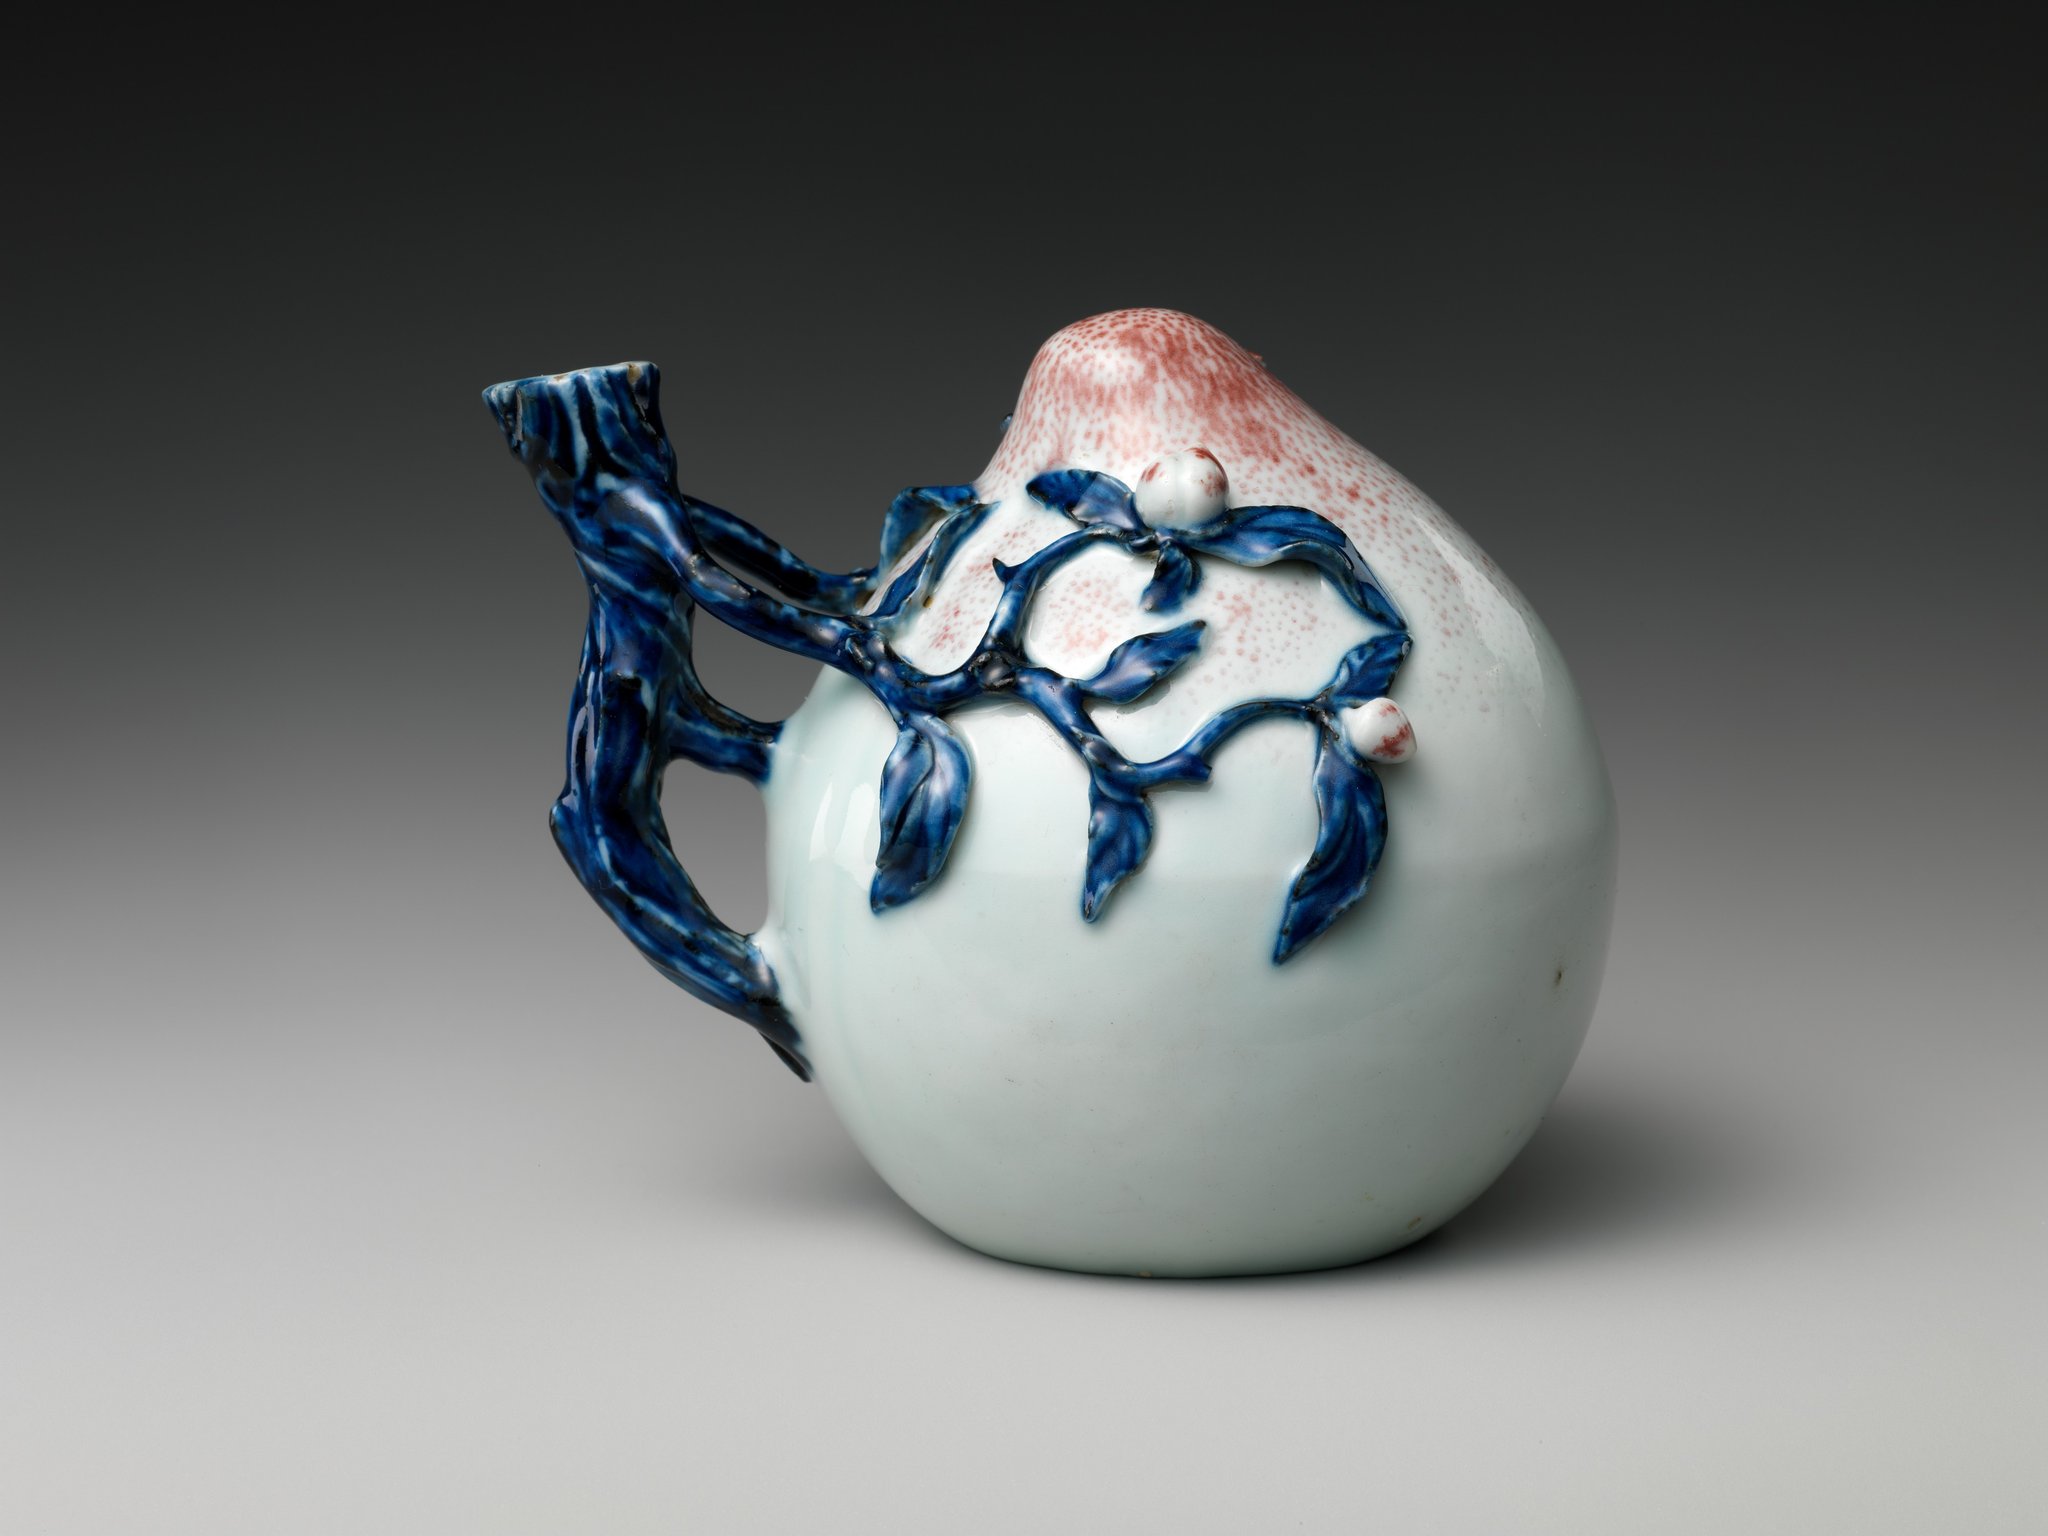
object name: ewer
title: Ewer in the shape of a peach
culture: chinese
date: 1801-1900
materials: cobalt, copper, glaze, porcelain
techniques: painting, underglaze